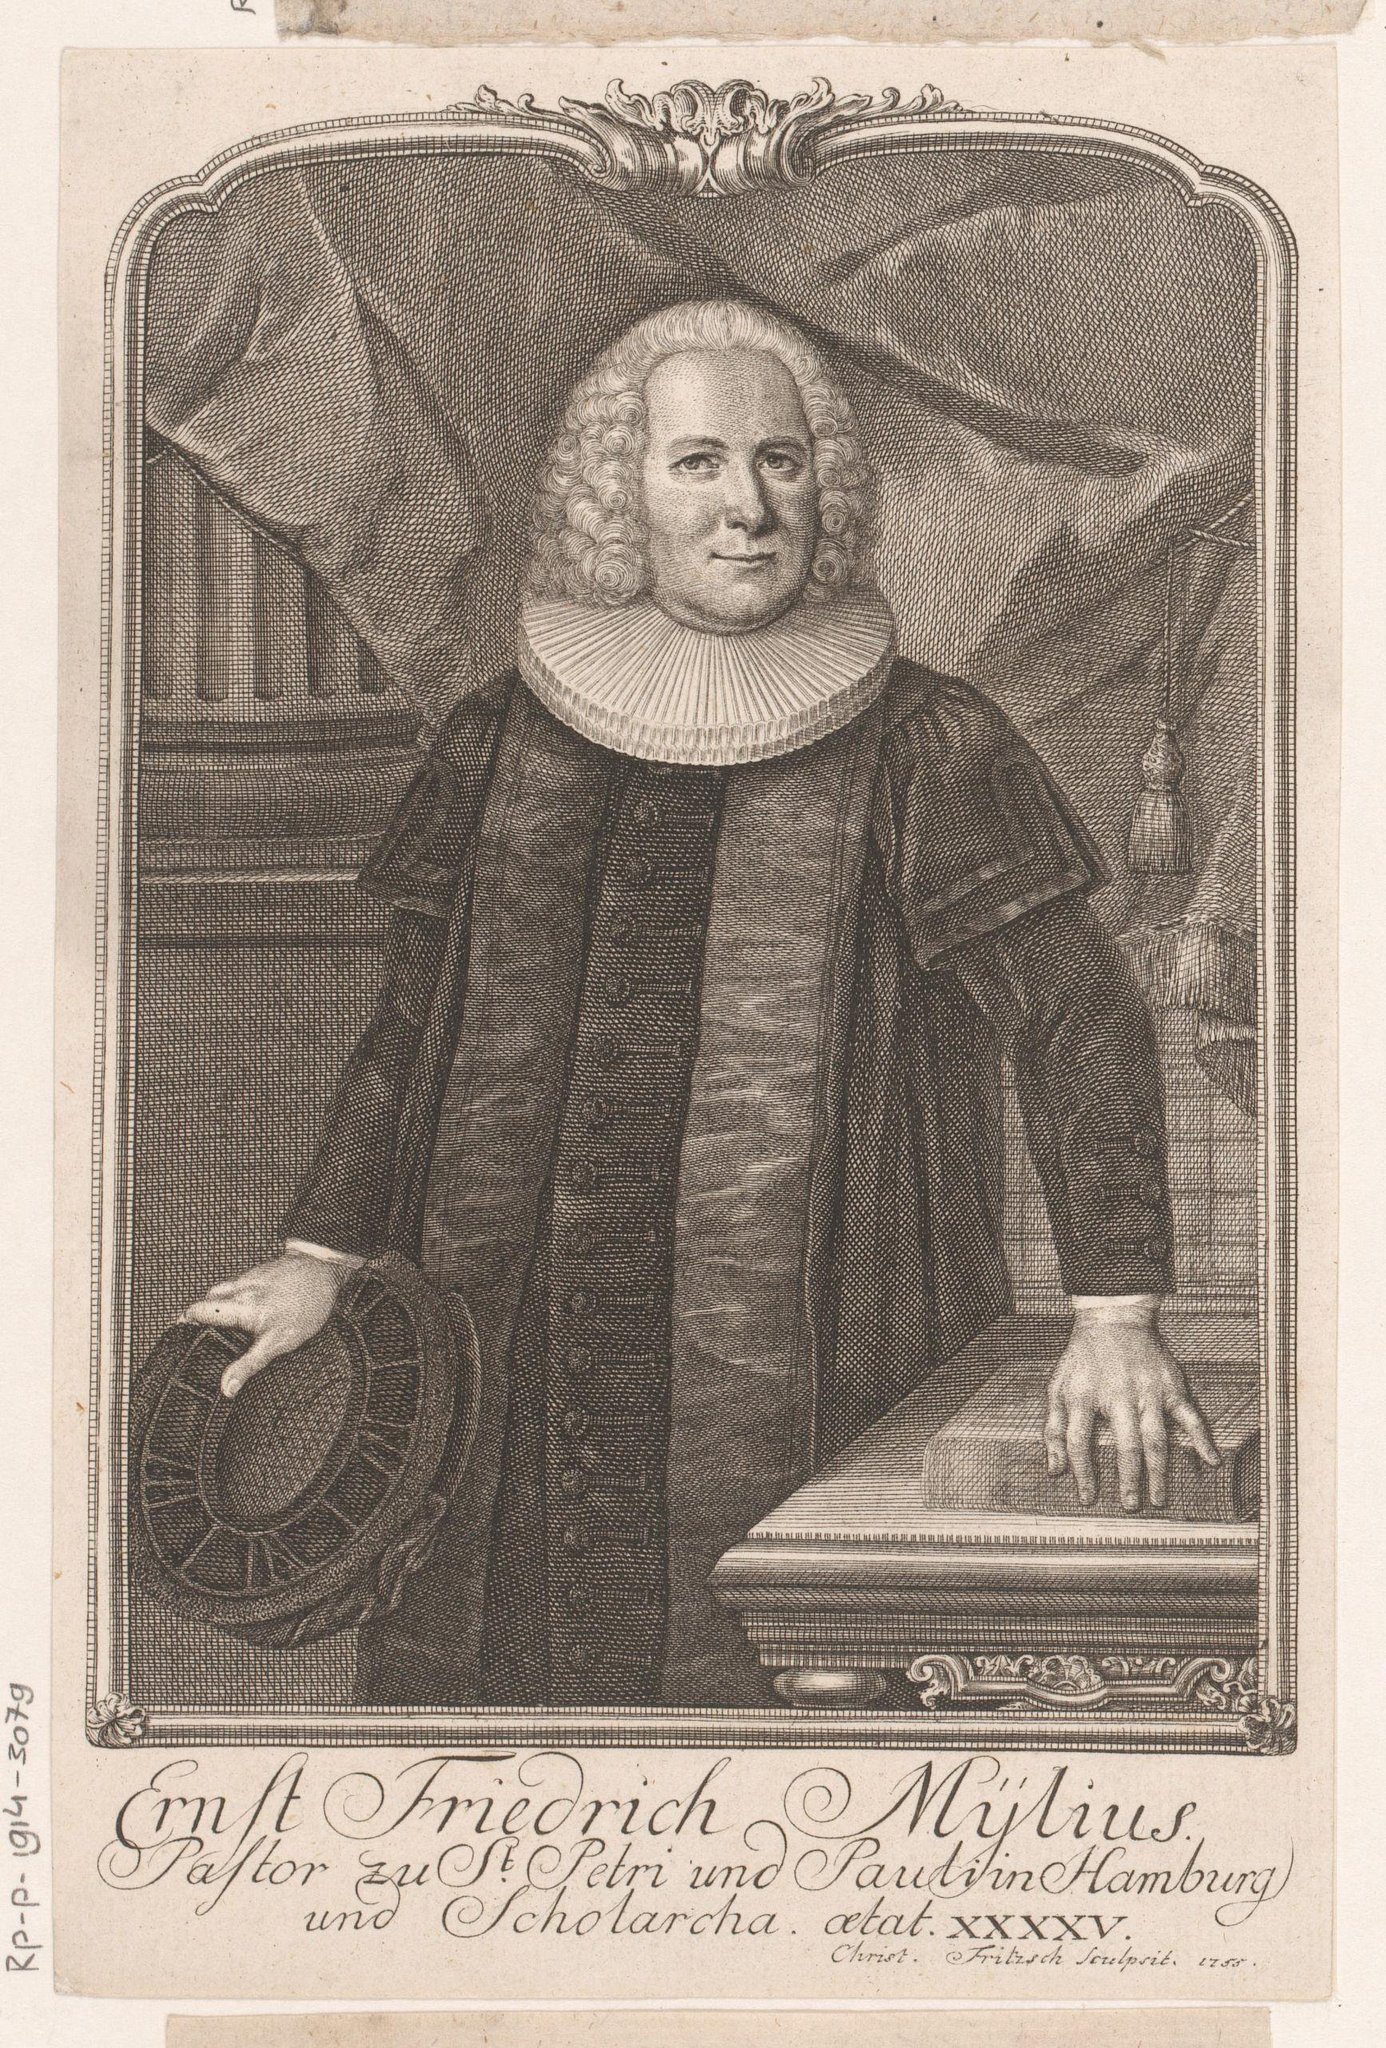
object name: print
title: Portret van Ernst Friedrich Mylius op 45-jarige leeftijd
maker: christian fritzsch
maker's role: print maker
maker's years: 1695-1769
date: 1755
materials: paper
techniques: engraving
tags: bookshelves, historical persons, head-gear: hat, book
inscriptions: collector's mark: Lugt 2228